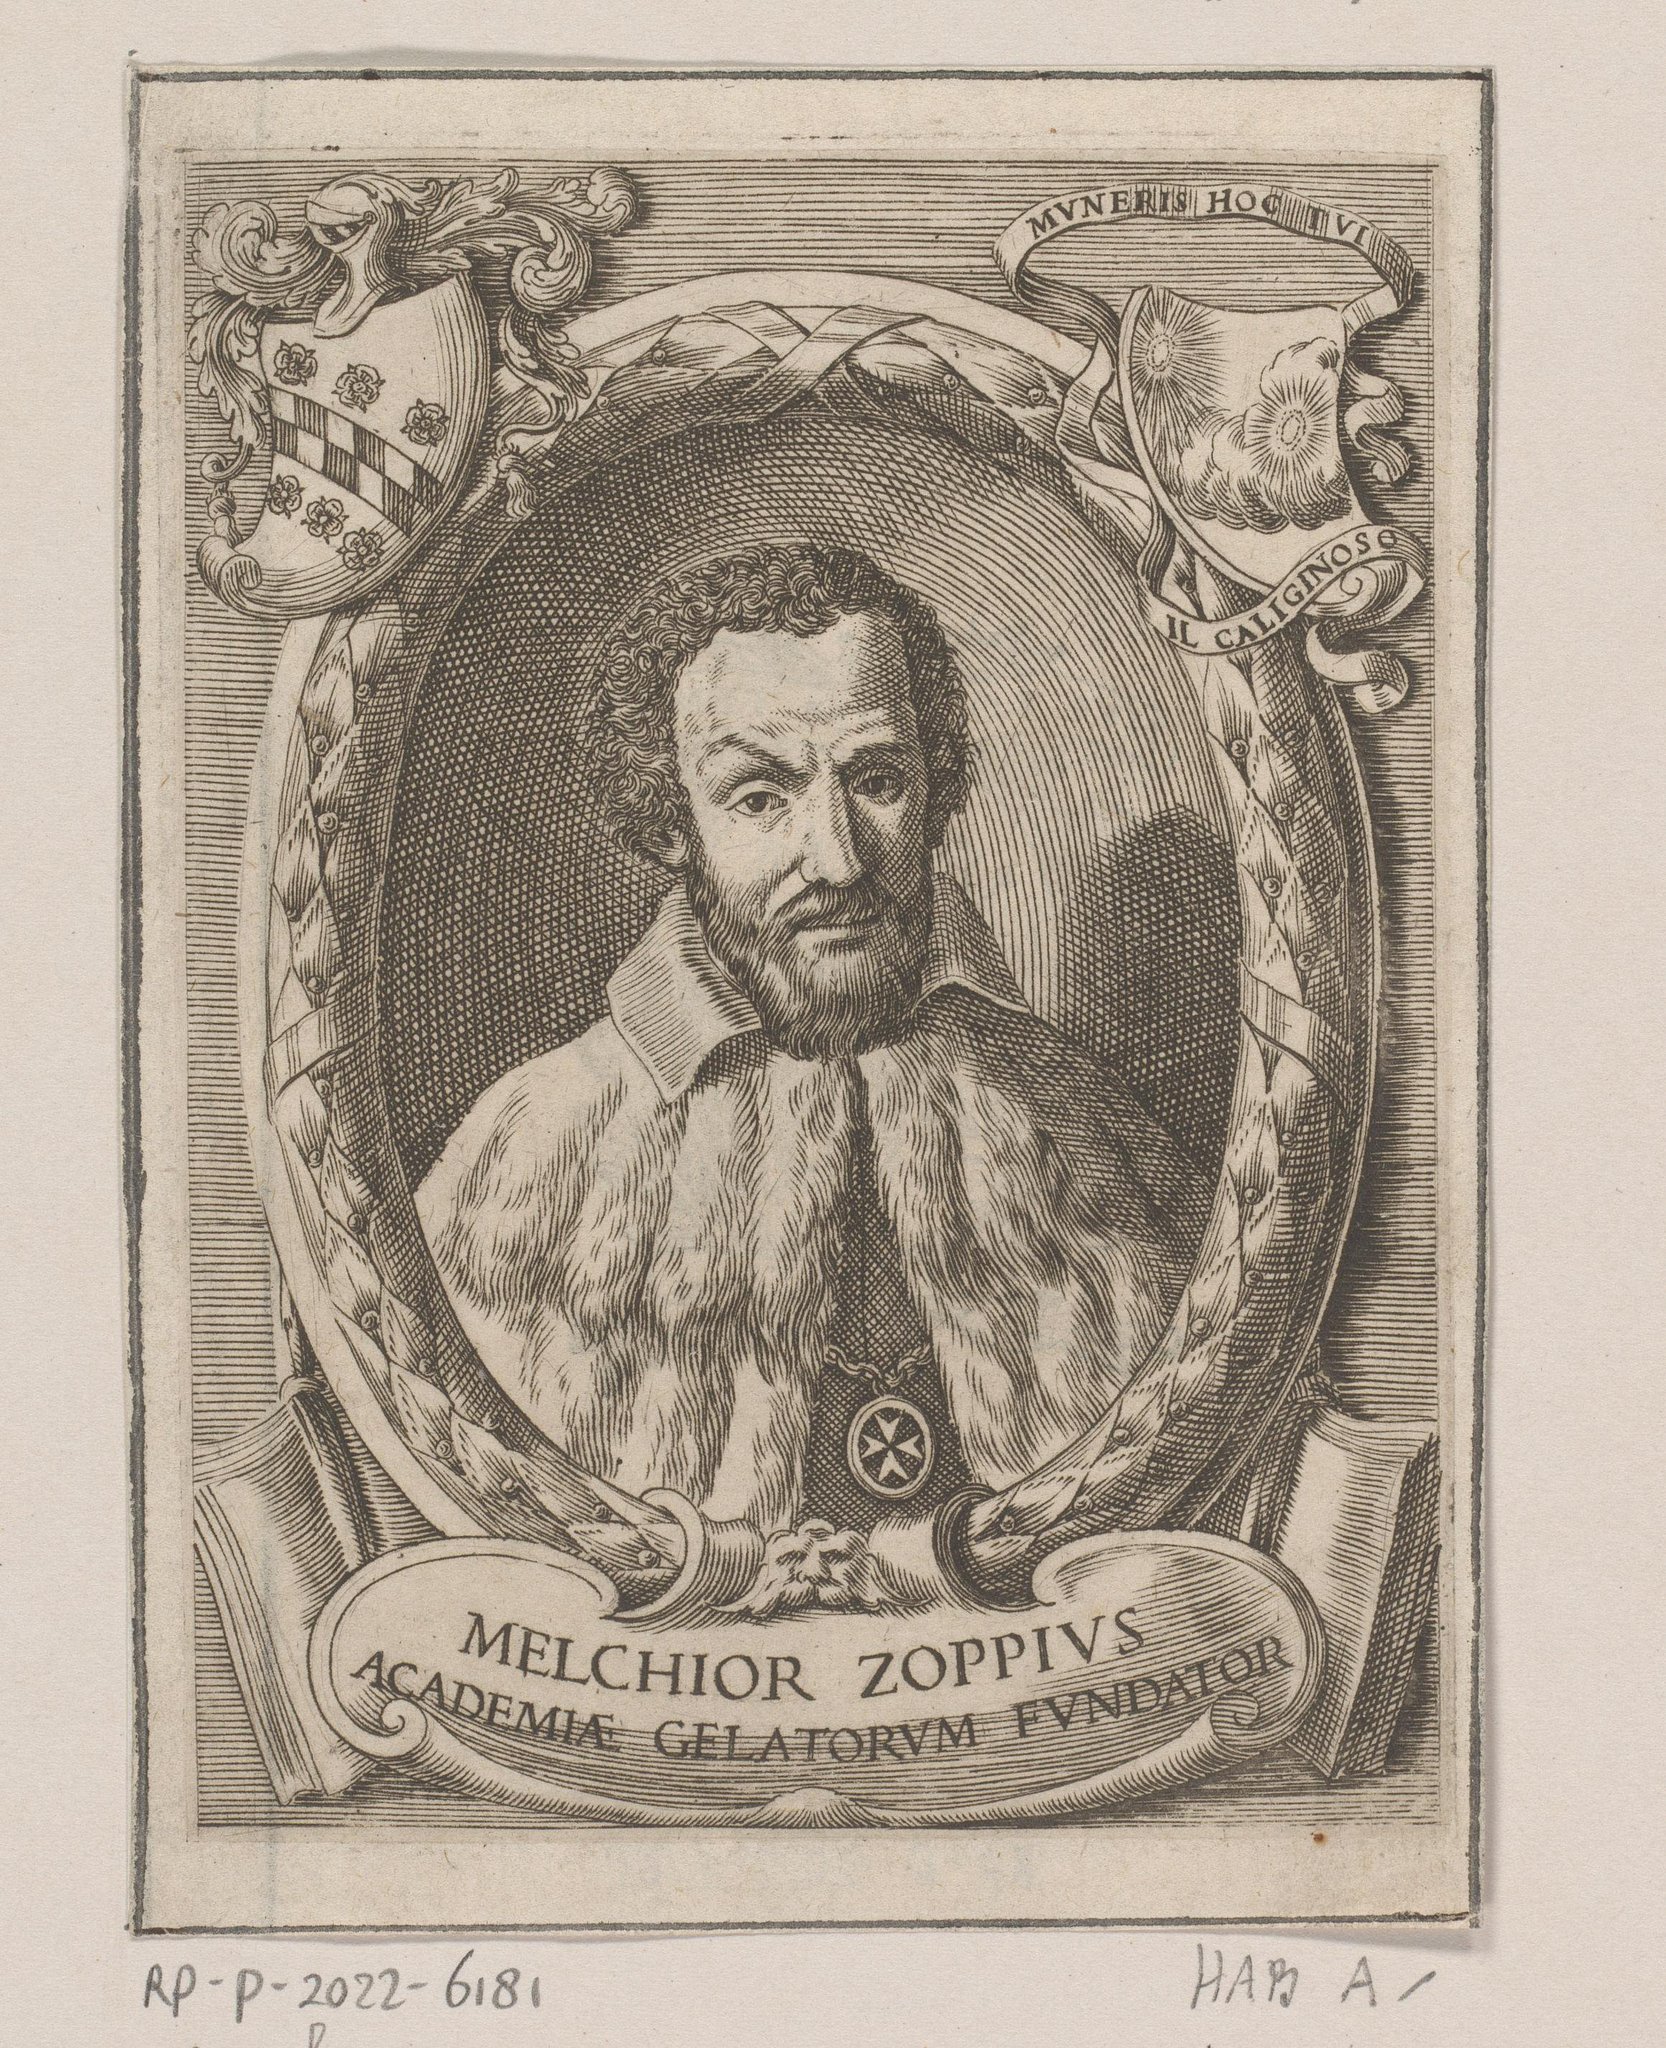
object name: print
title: Portret van Melchiorre Zoppio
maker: Anonymous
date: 1588-1650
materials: paper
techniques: engraving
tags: historical persons, professor, scholar, philosopher (+ portrait of scholar, scientist)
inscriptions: stamp: ‘NEC LONGUM TEMPUS / I GELATI’